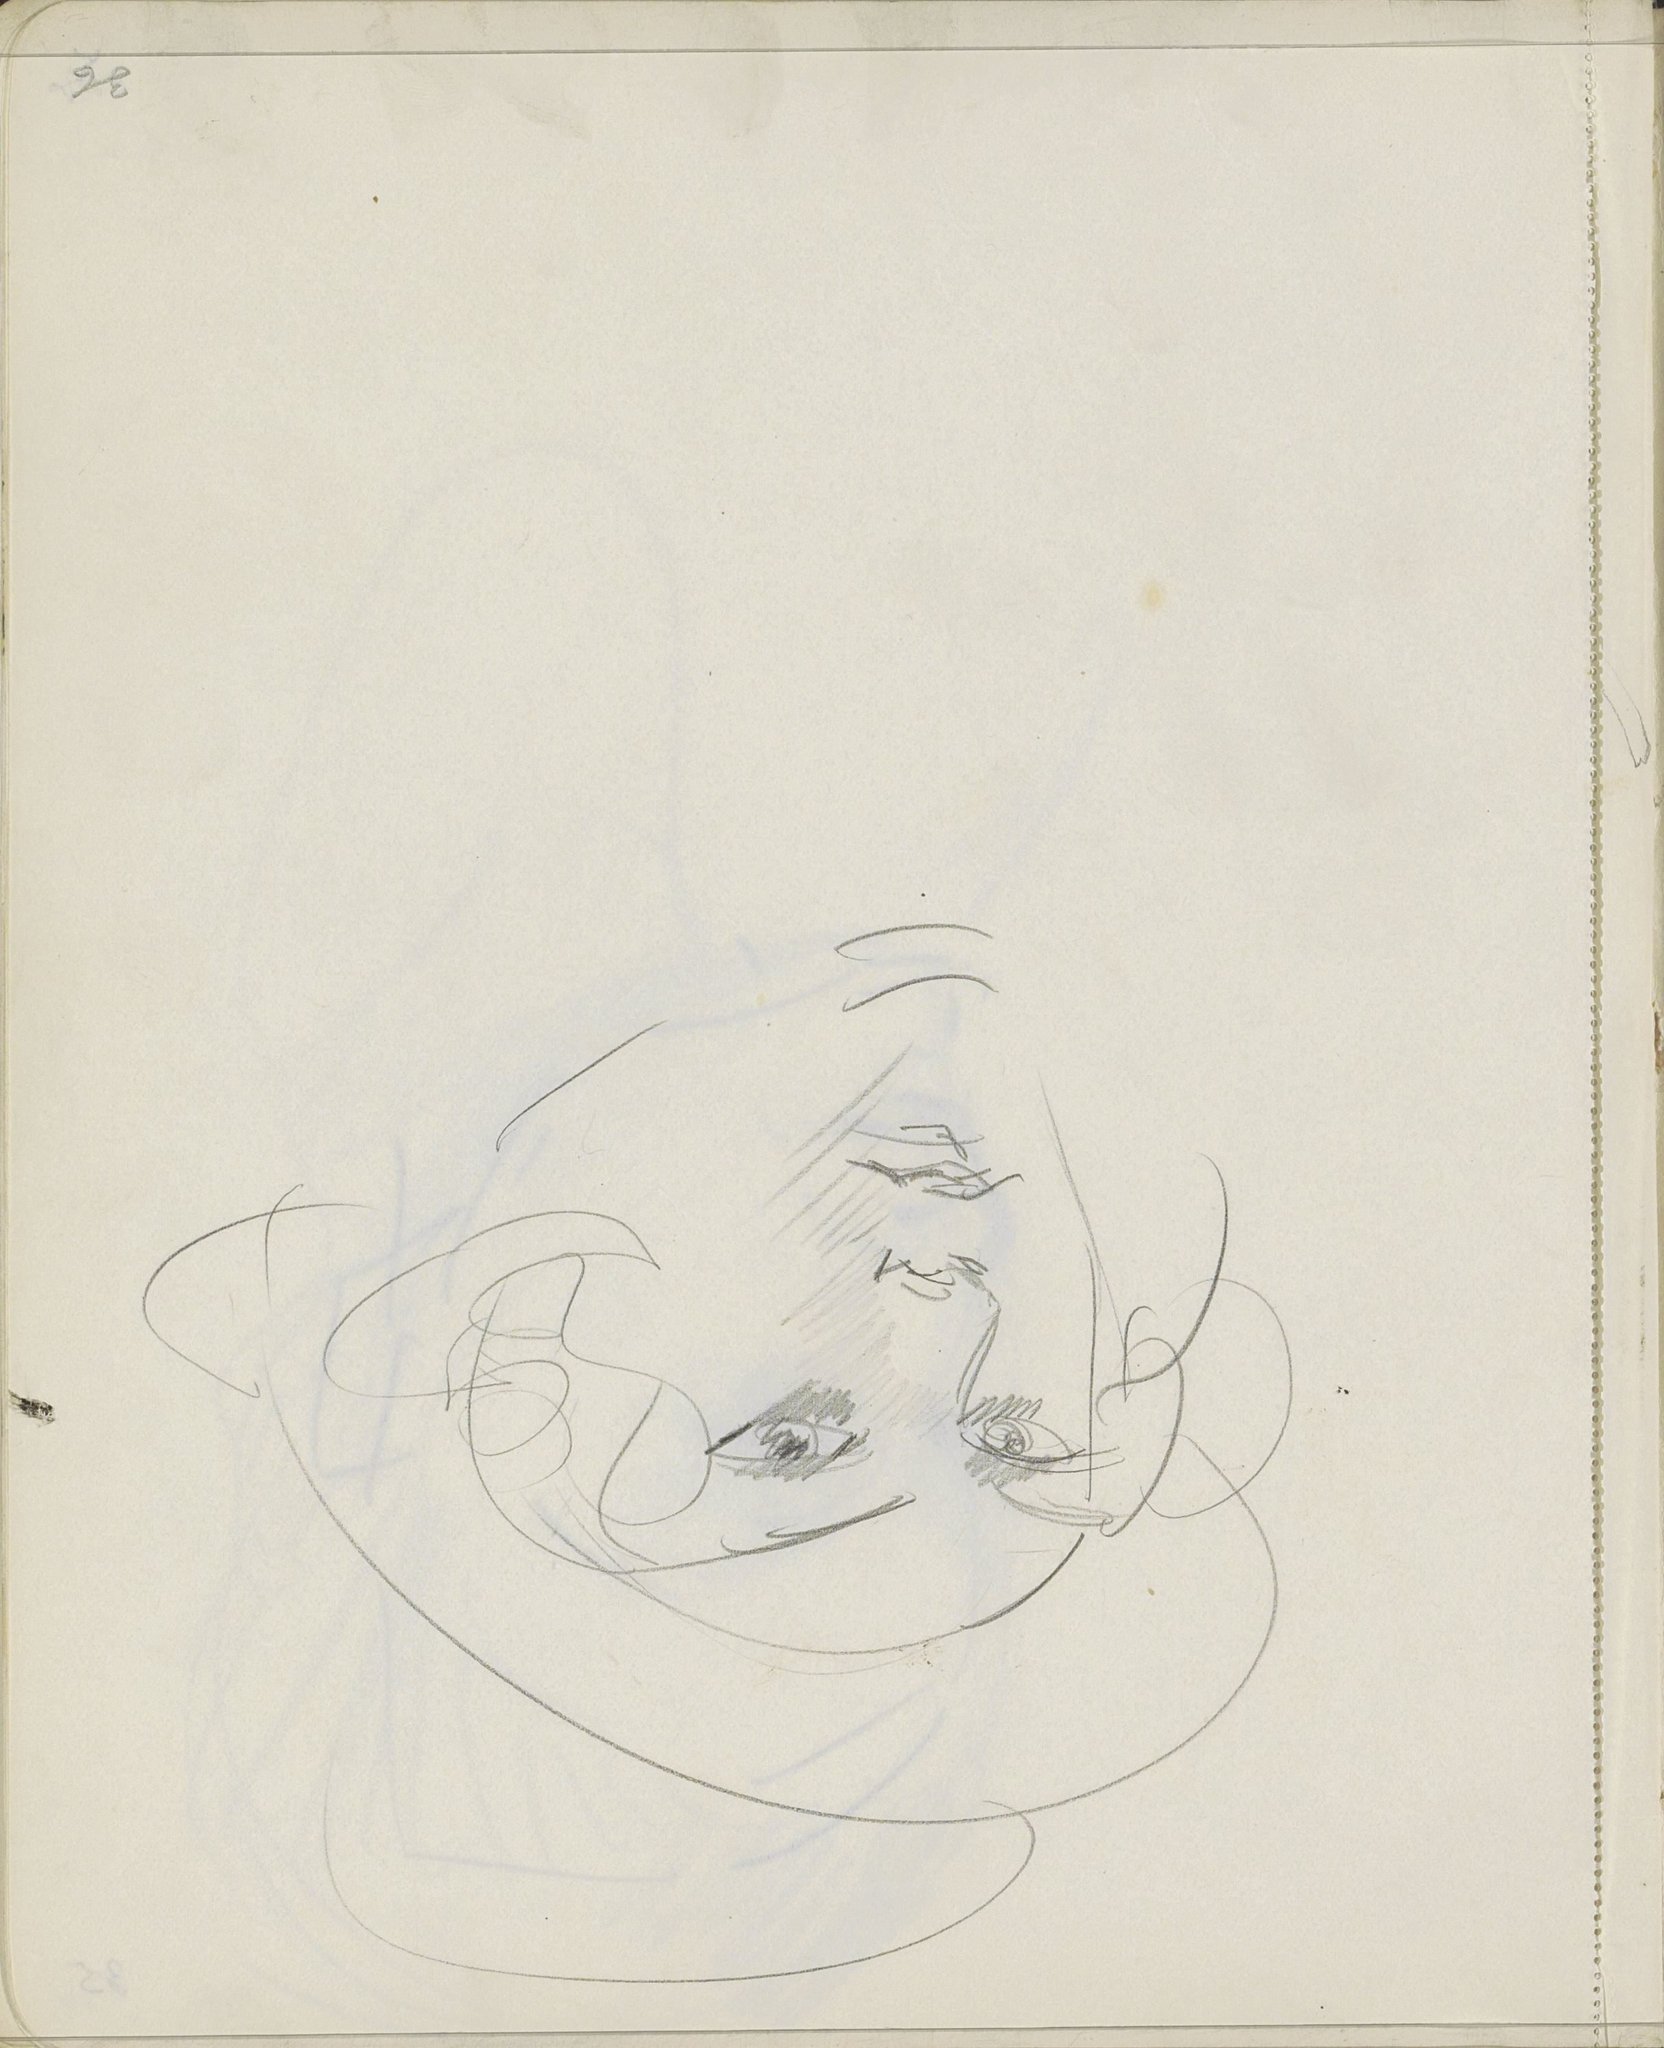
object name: sketchbook leaf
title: Vrouwenhoofd met hoed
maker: isaac israels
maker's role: draughtsman, painter, print maker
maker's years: 1865-1934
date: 1925-1934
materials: paper, pencil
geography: the hague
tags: head-gear: hat (+ women's clothes), head (human) - aa - female human figure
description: Blad 35 verso uit schetsboek XXVI met 35 bladen.